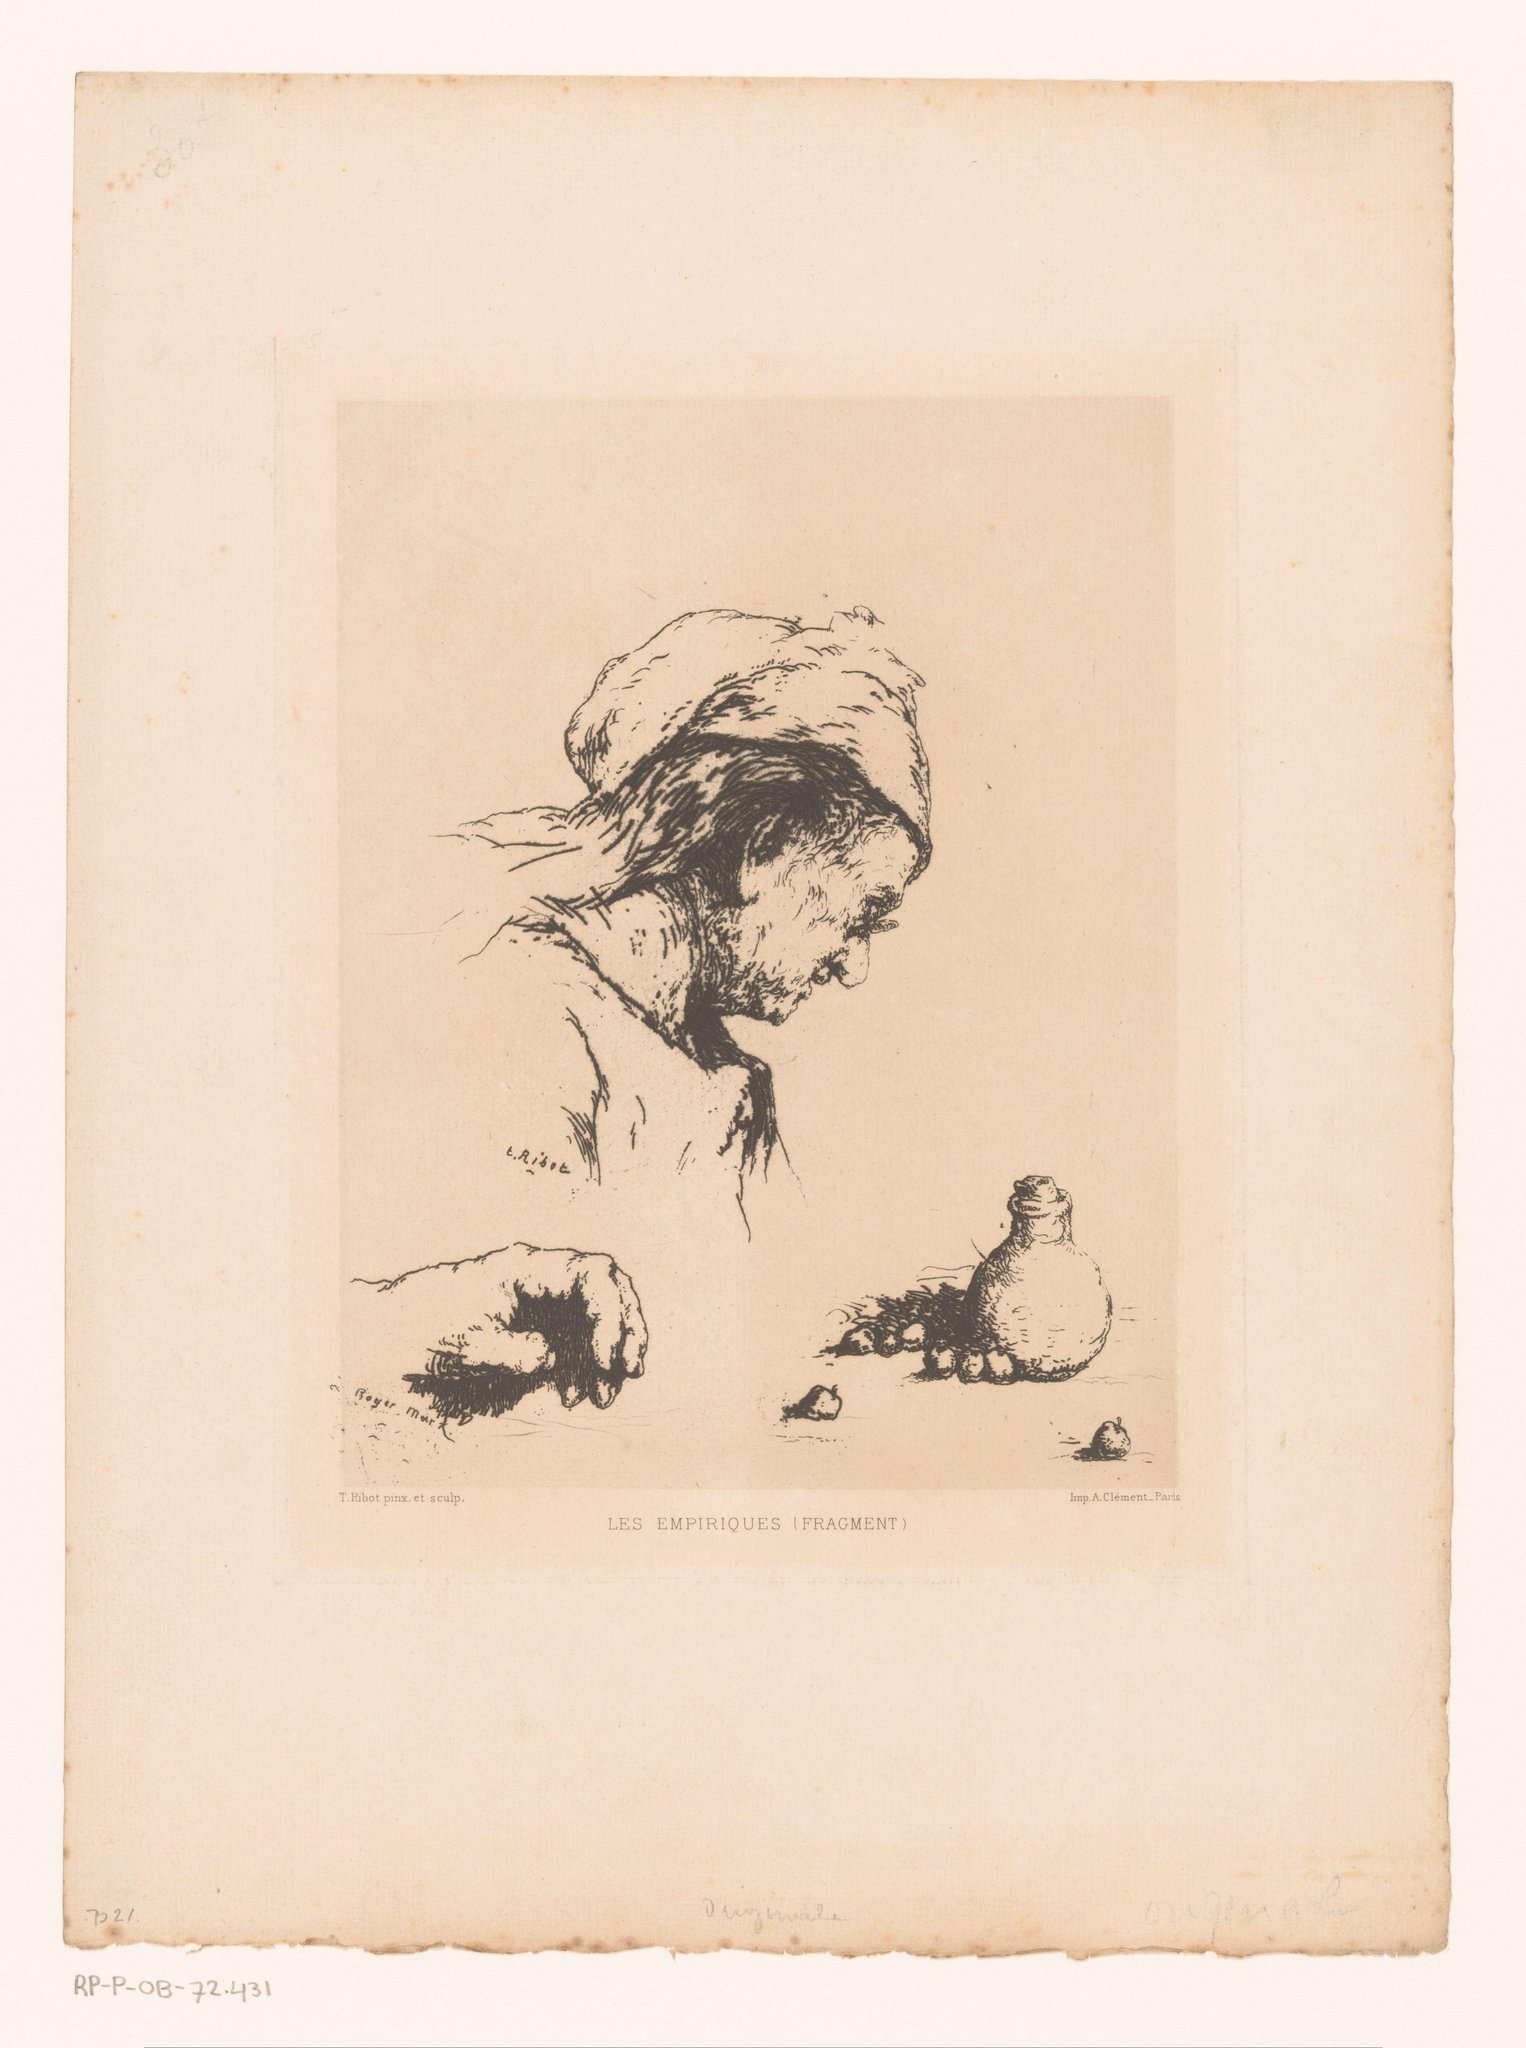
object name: print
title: Compositie met hoofd van een oude vrouw, een hand en een kruik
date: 1833-1891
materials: paper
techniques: drypoint, etching, intaglio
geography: paris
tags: old woman, postures and gestures of arms and hands, container of ceramics: jar, jug, pot, vase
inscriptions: collector's mark: Lugt 2166